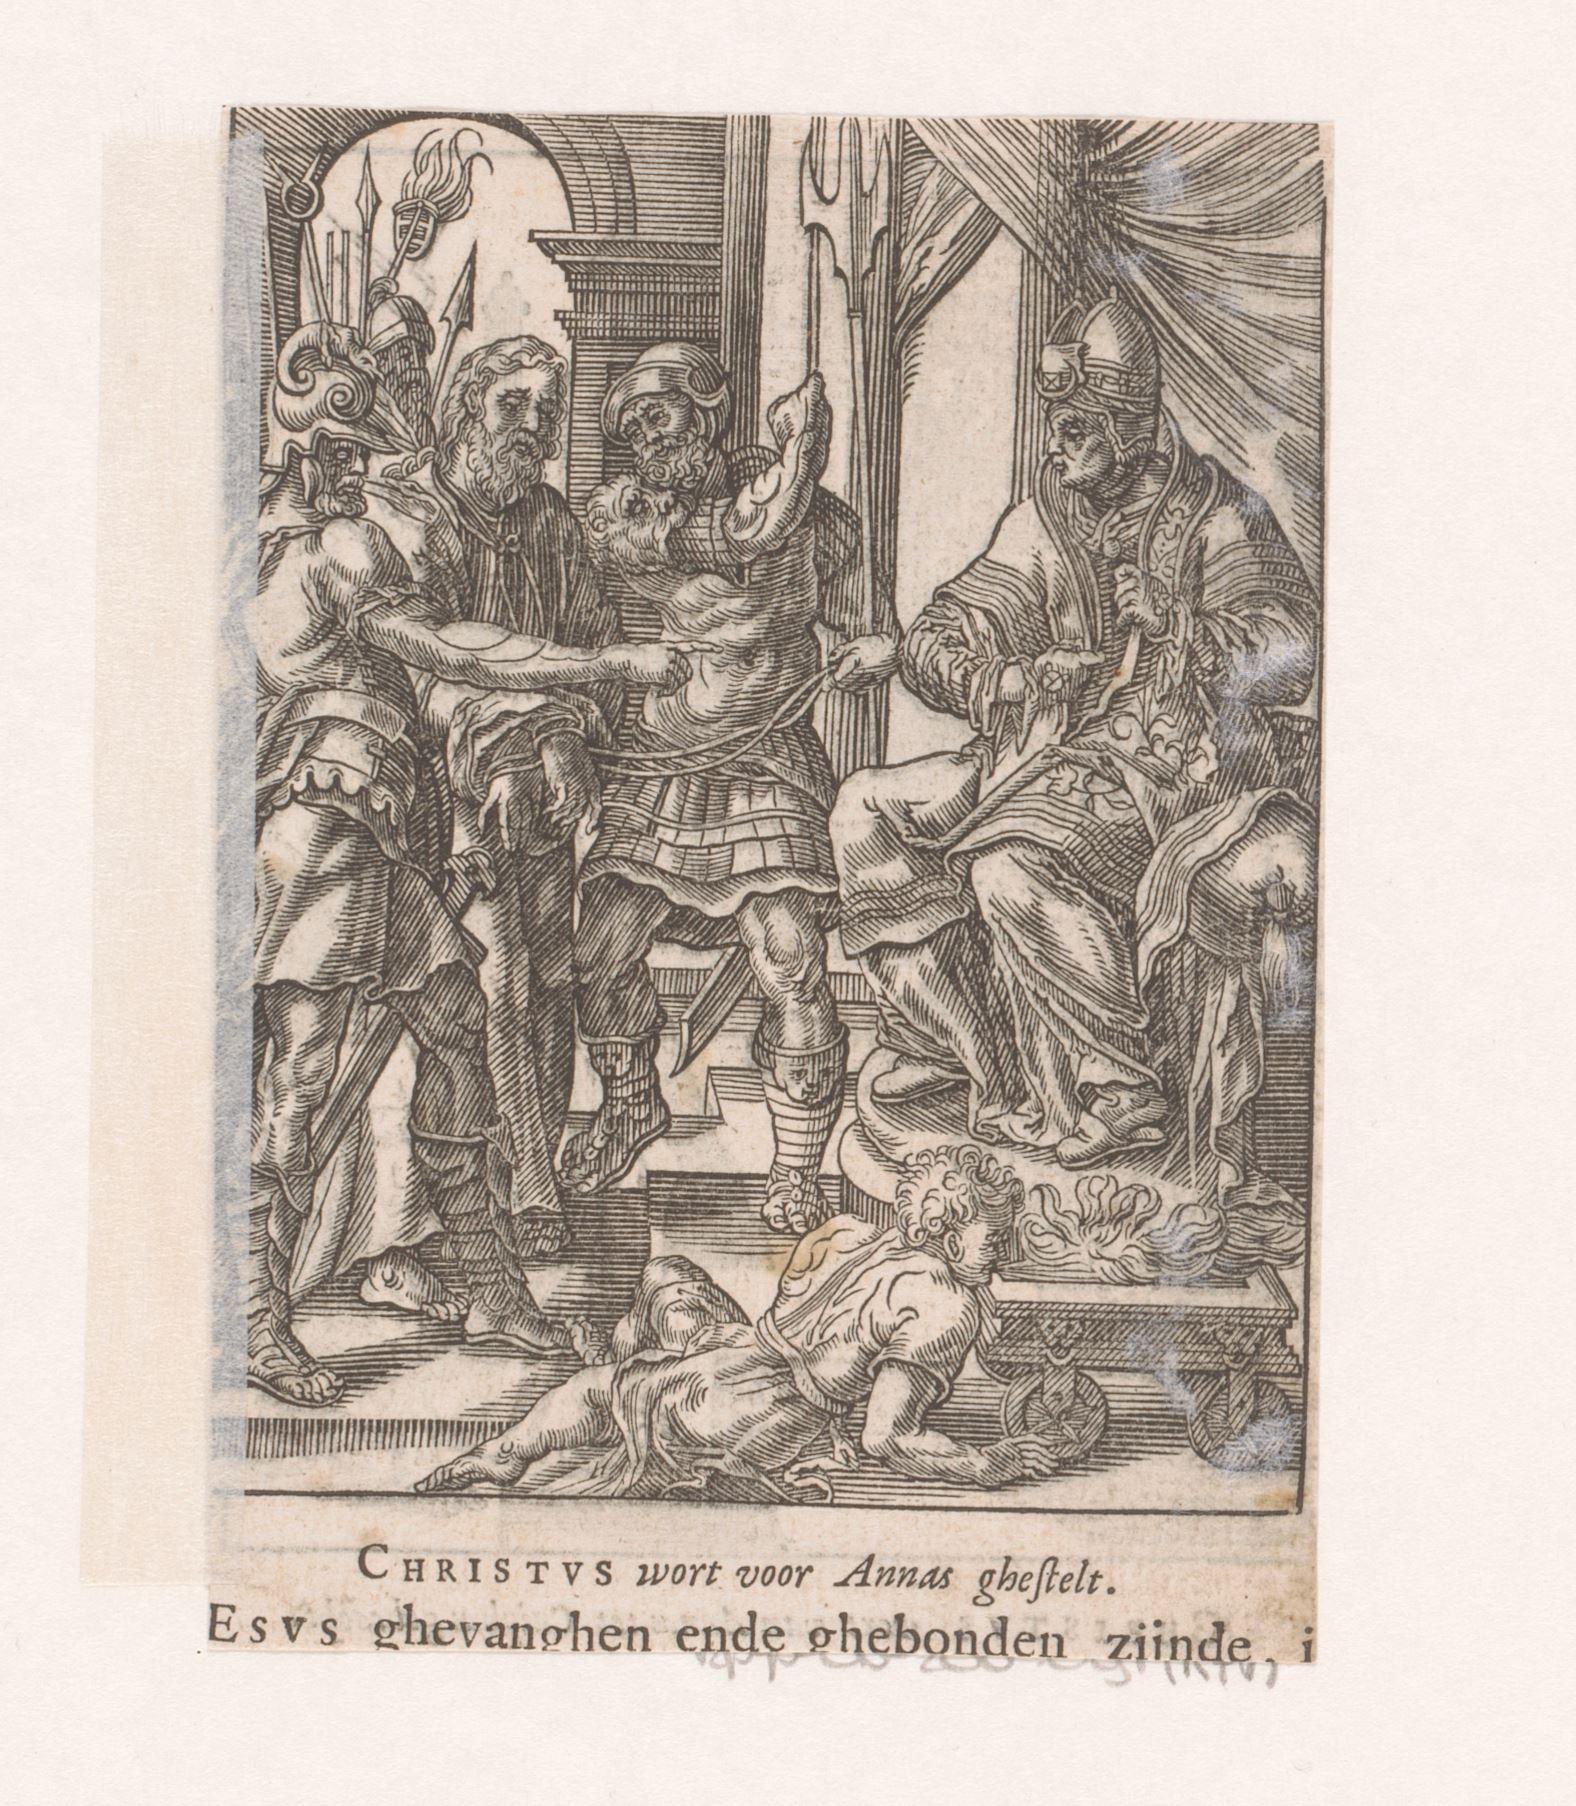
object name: print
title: Christus wort voor Annas ghestelt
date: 1648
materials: paper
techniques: letterpress printing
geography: amsterdam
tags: christ before annas (hanna); maybe a soldier about to strike christ (john 18:13, 18:19-24)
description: Prent uit: 't Schat der Zielen, dat is, het geheele leven ons Heeren Iesu Christi naer de vyer Evangelisten (...) in zeven stucken verdeelt. Amsterdam: Pieter Jacobsz. Paets, 1648. Deze prent komt uit het vijfde deel of hoofdstuk van 't Schat der zielen: Passie ons Heeren Iesu Christi, naer de beschrijvinghe van de vier evangelisten. Binnen het vijfde deel hoort deze prent bij de beschrijving van de passie door Lucas.